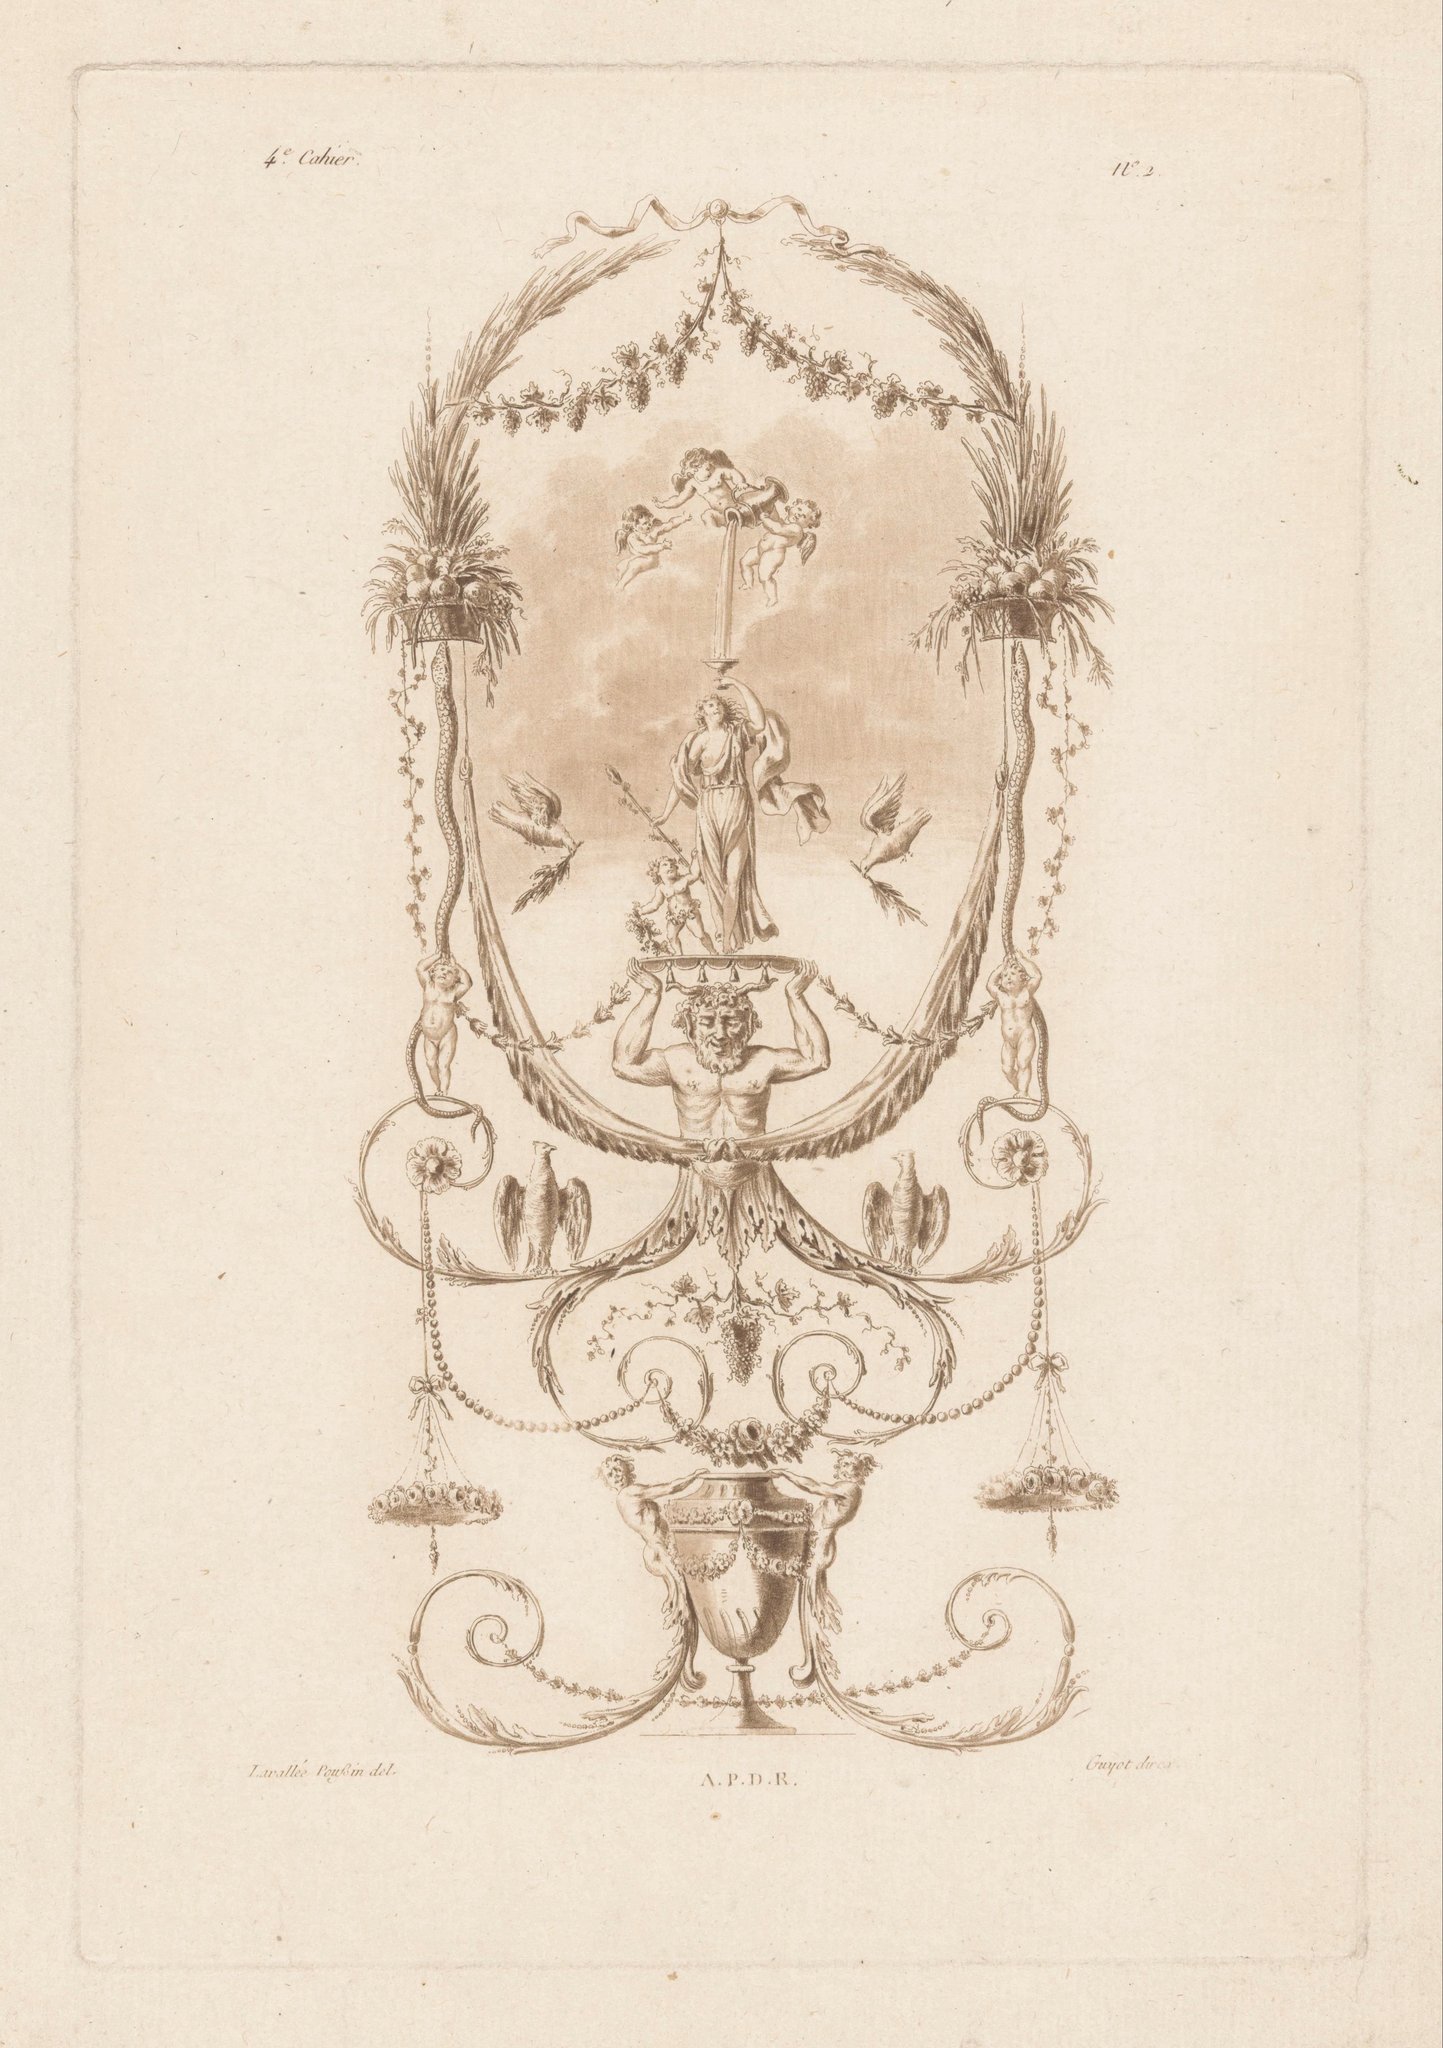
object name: ornament print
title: Nouvelle Collection D'Arabesques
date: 1788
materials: paper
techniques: aquatint, etching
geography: paris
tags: ornament ~ arabesque, chalice, standing figure - aa - female human figure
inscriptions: collector's mark: Lugt 2228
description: Een sater draagt een plateau waarop een putto met druivenranken en een vrouw met een thyrsus en een kelk staan. Daarboven vliegen drie putti met een kan, zij schenken iets in de kelk van de vrouw. Rondom het geheel arabesken, guirlandes, manden met fruit, slangen, putti, vogels en aan de onderzijde een vaas.